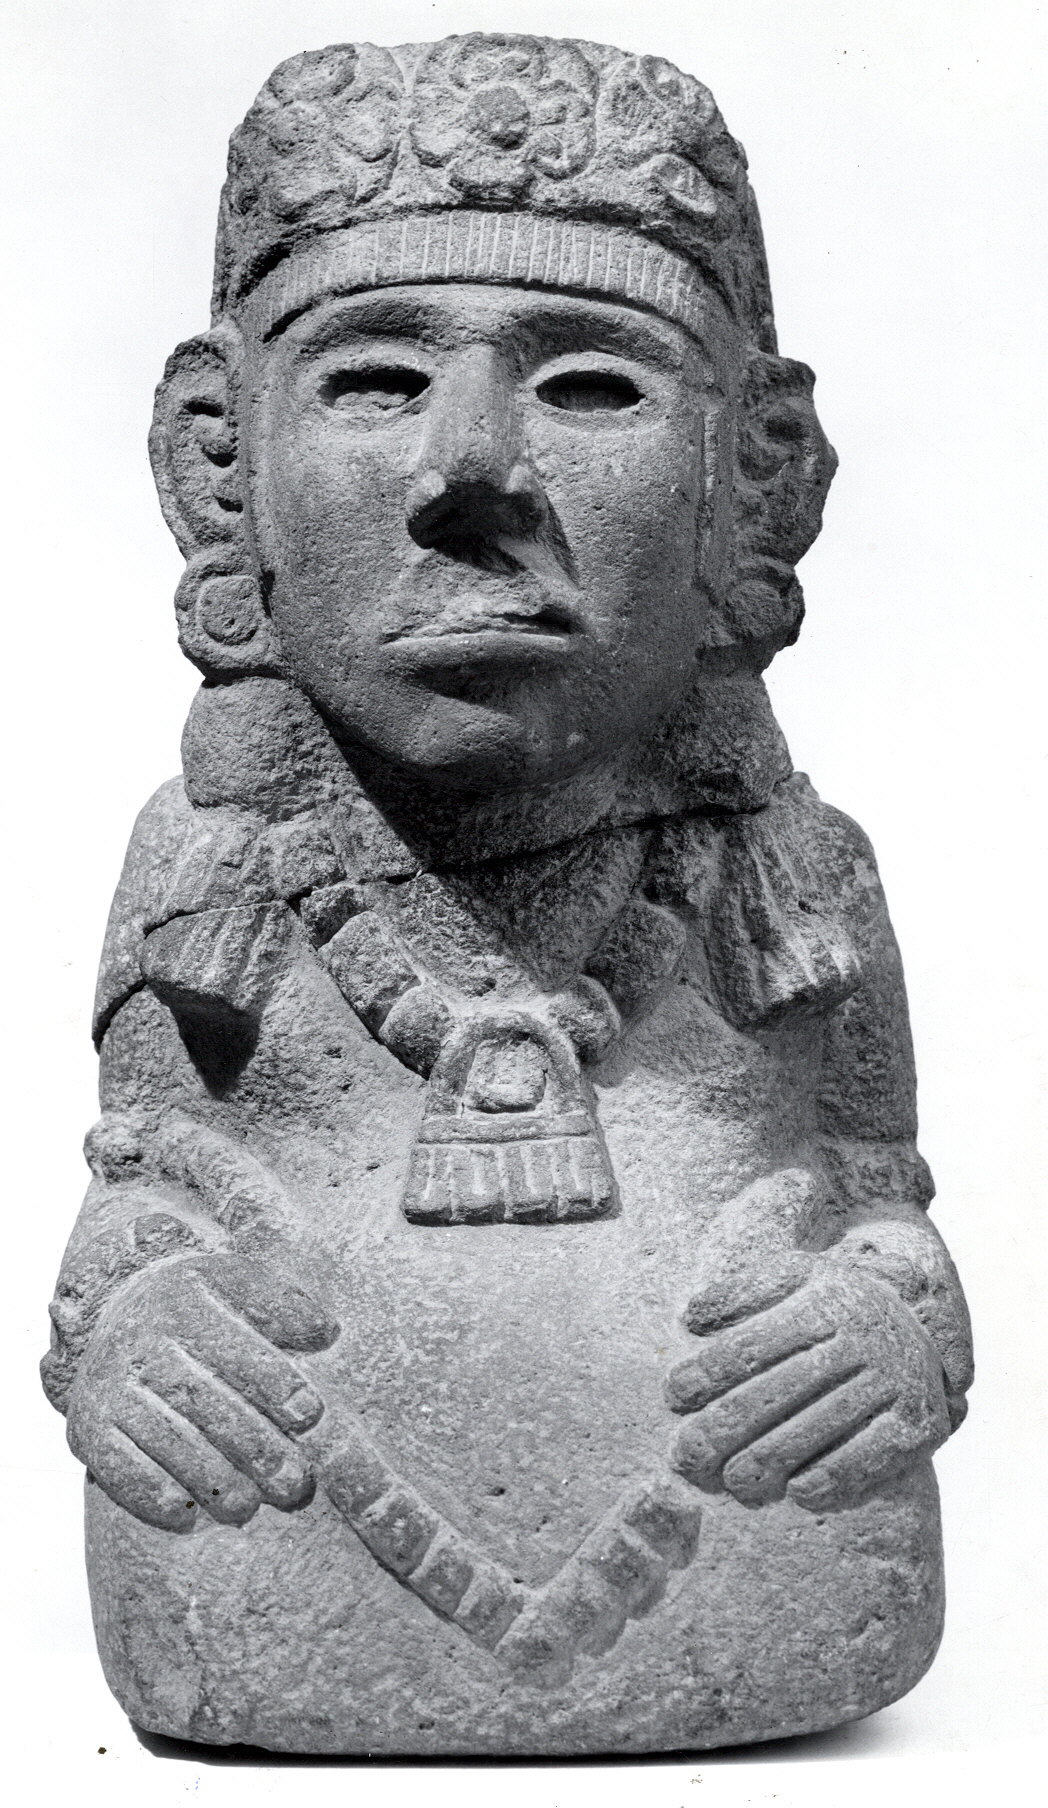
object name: female figure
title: Seated Female Deity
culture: mexica, aztec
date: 1401-1533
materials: stone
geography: mexico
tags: deities